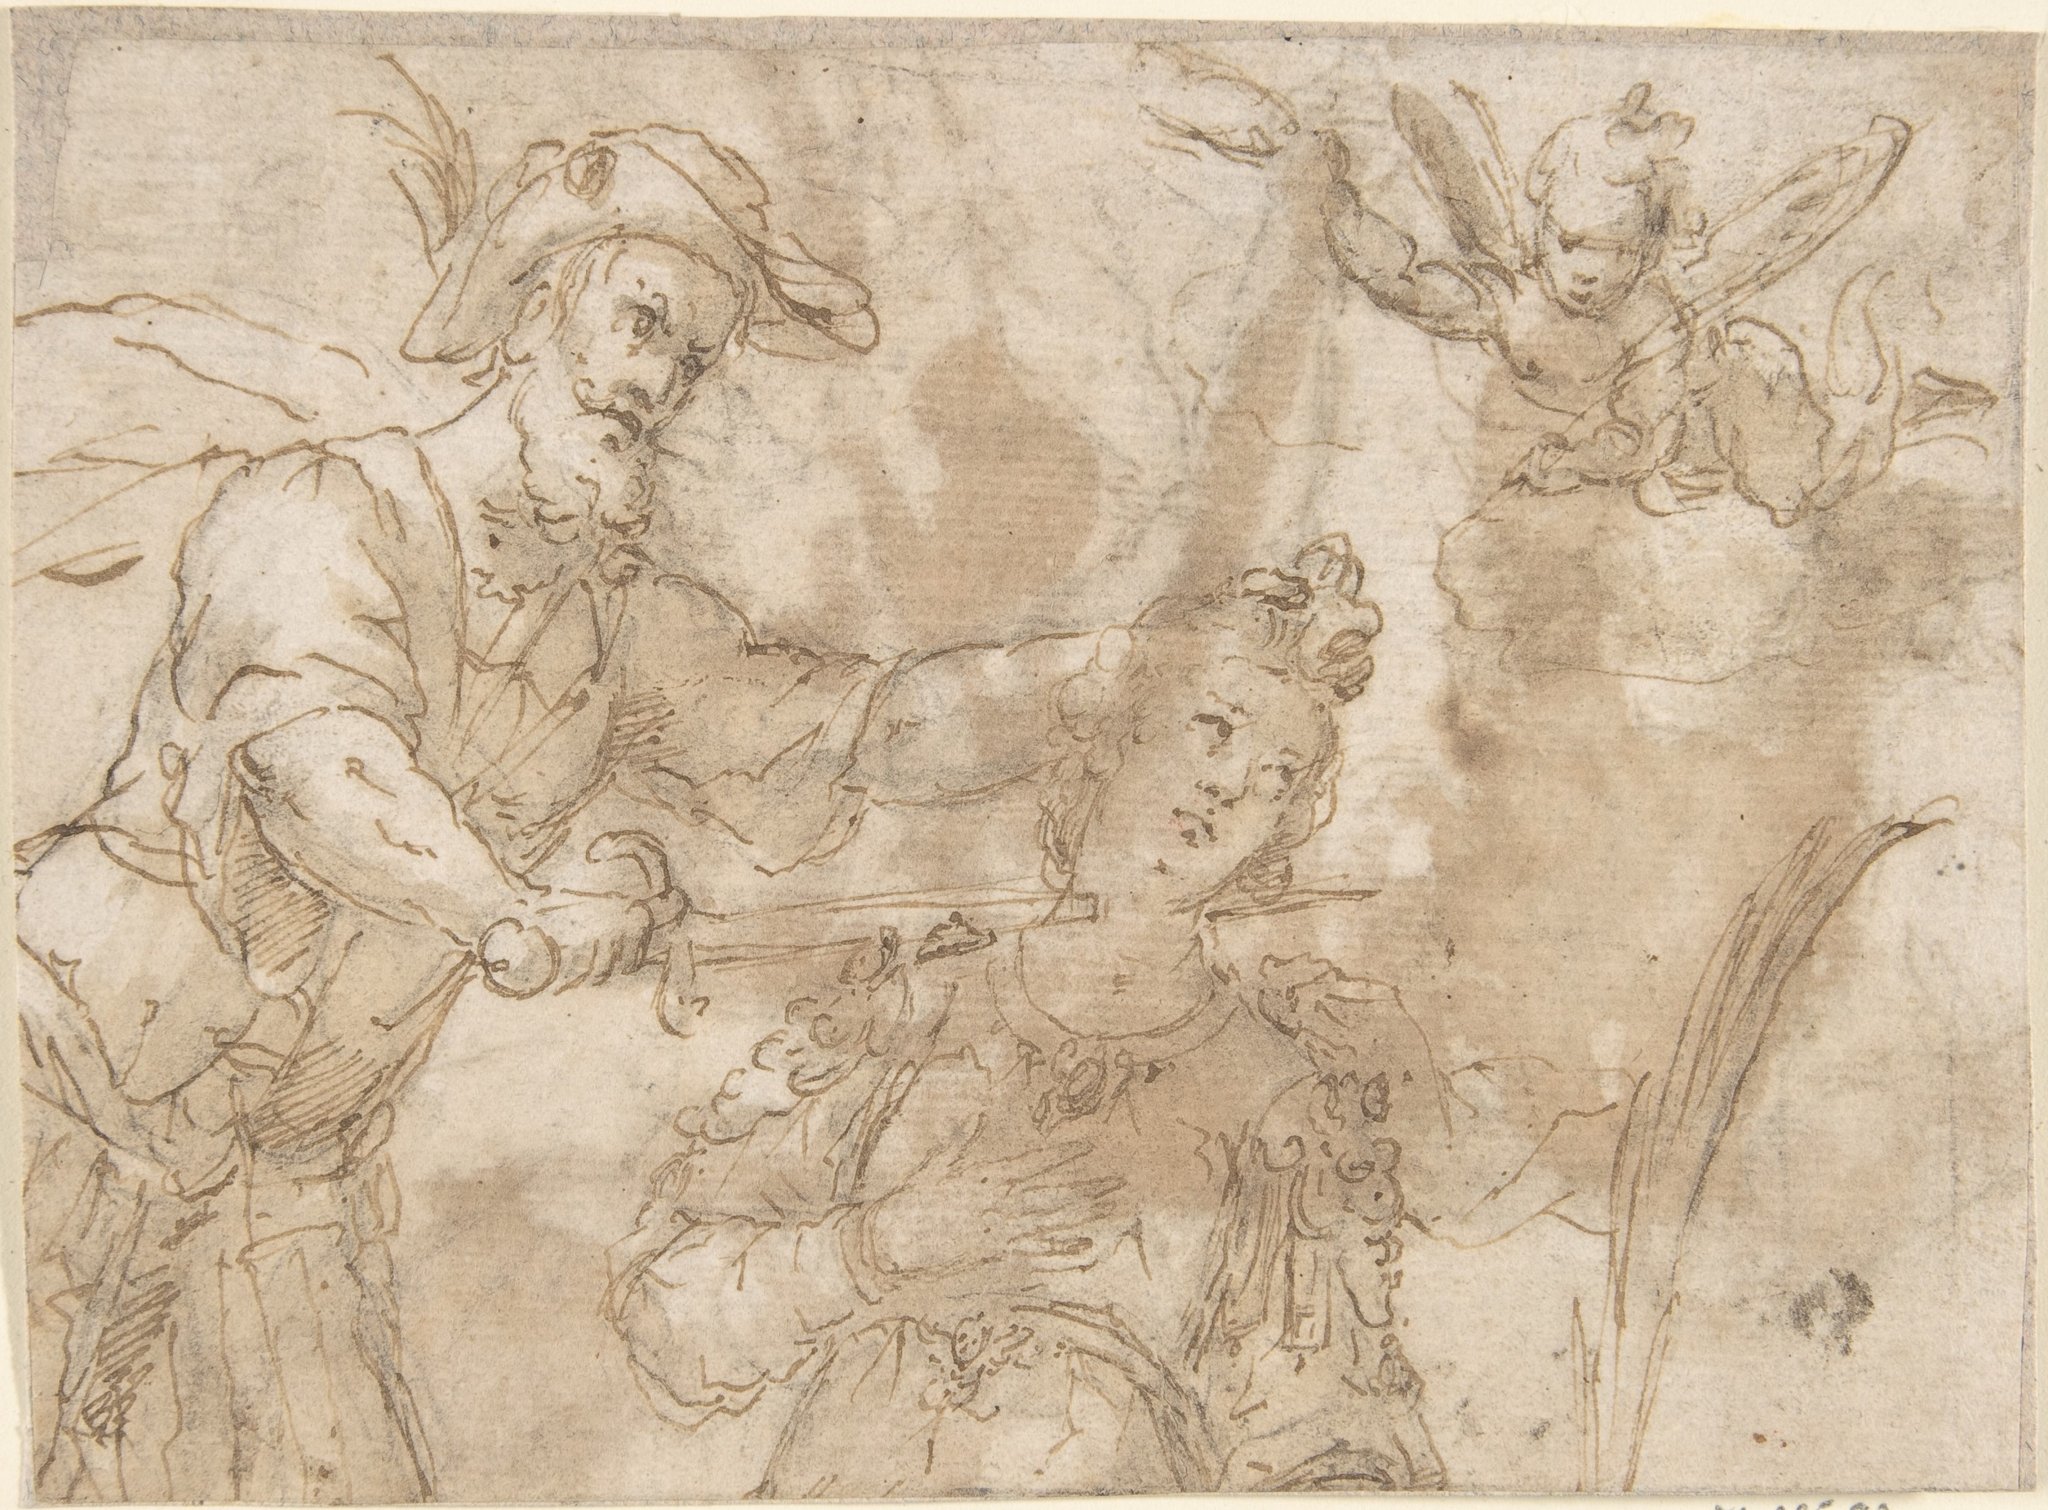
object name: drawing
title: Decapitation of a Female Martyr (Saint Catherine of Alexandria?)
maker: anonymous, spanish, school of seville, 17th century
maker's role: artist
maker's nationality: spanish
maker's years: 1600-1700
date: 1601-1700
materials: chalk, ink, paper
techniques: brush, pen, drawing, wash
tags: women,putti,saint catherine